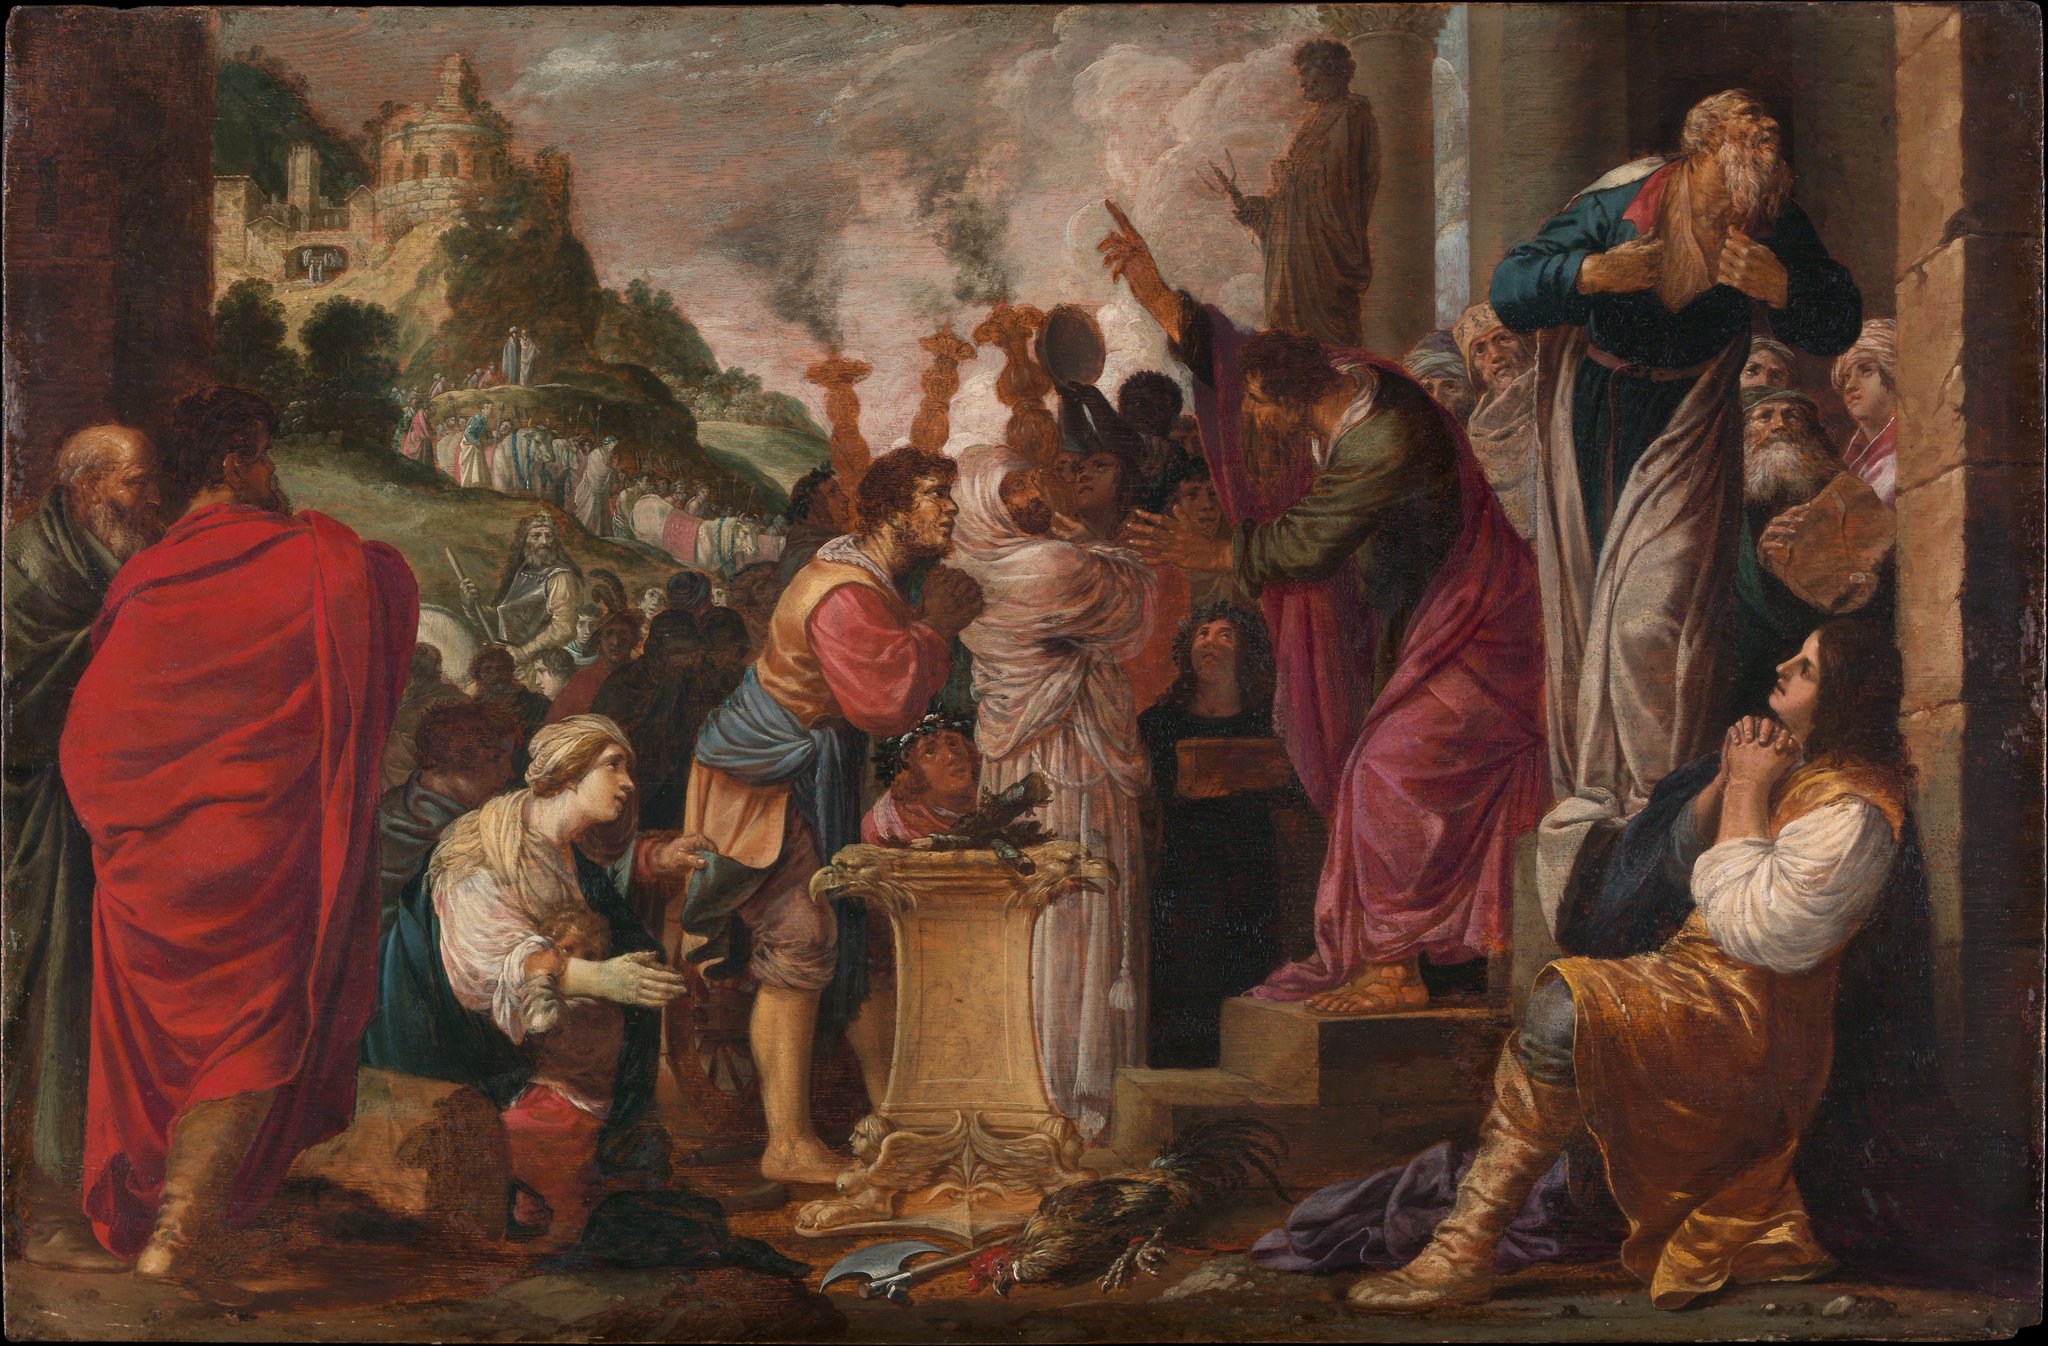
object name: painting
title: Paul and Barnabas at Lystra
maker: jacob pynas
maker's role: artist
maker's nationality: dutch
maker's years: 1592-1650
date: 1605-1650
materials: oil, wood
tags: men,women,roosters